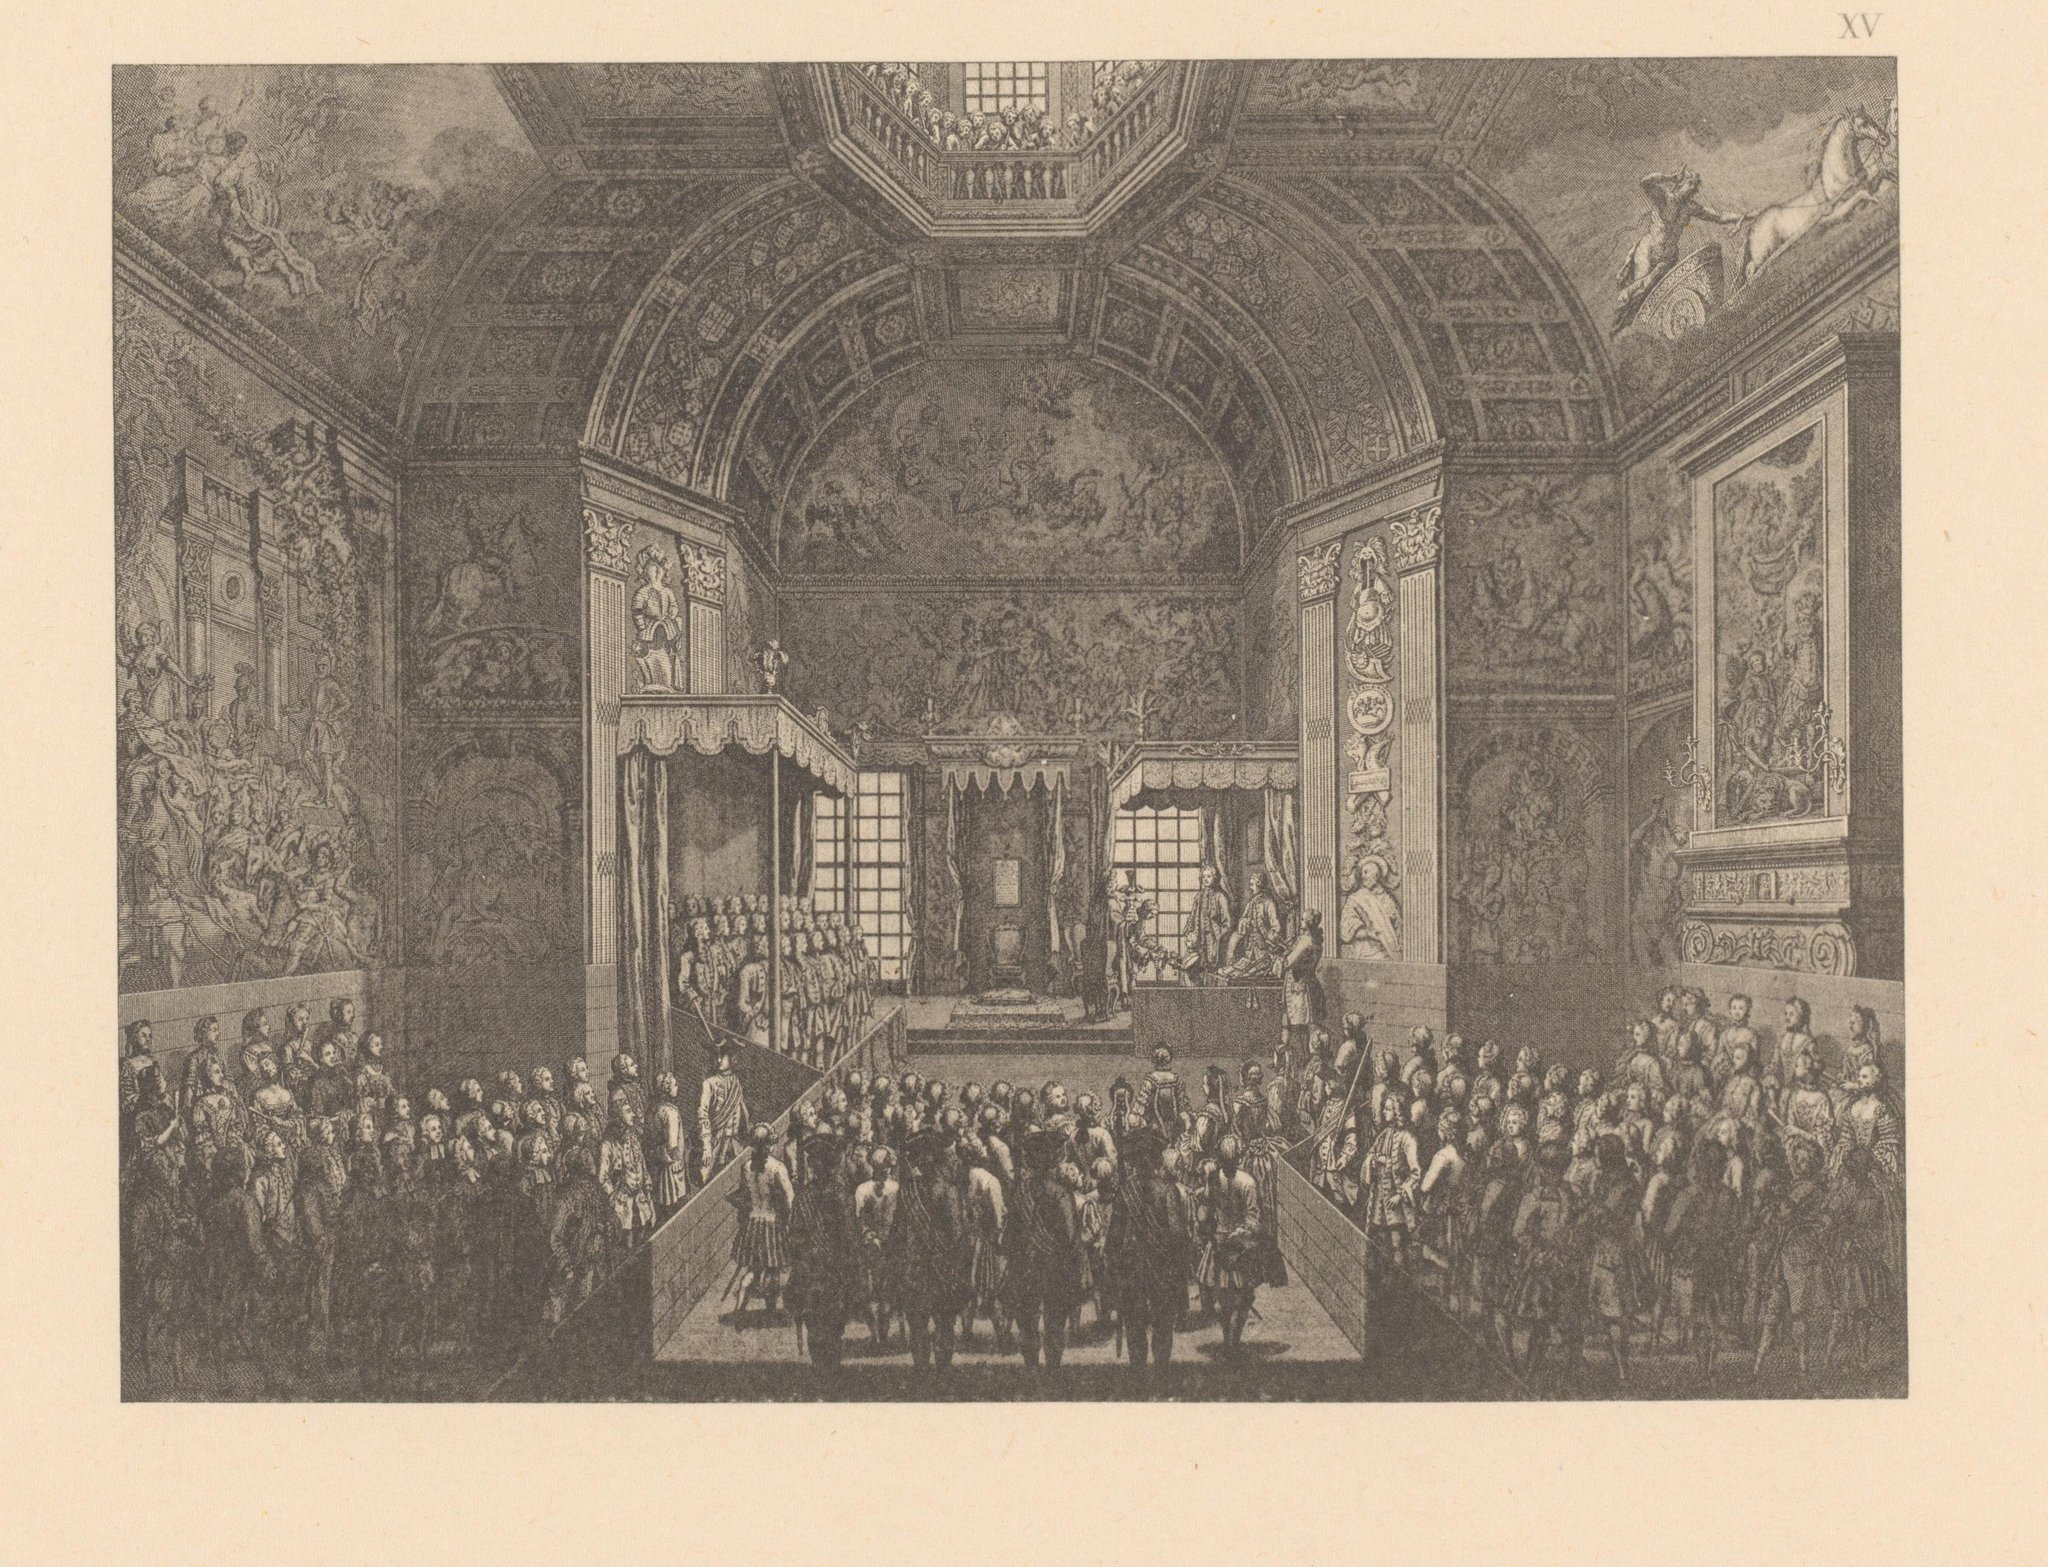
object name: photomechanical print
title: Reproductie van een prent van de inhuldiging van prins Willem V tot Ridder in de Orde van de Kousenband door Jan Caspar Philips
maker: Anonymous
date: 1875-1900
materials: paper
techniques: photograph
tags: the hague, william v (prince of orange), knighting ceremonies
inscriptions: number: ‘4048’, number: ‘AA405’, collector's mark: Lugt 2228